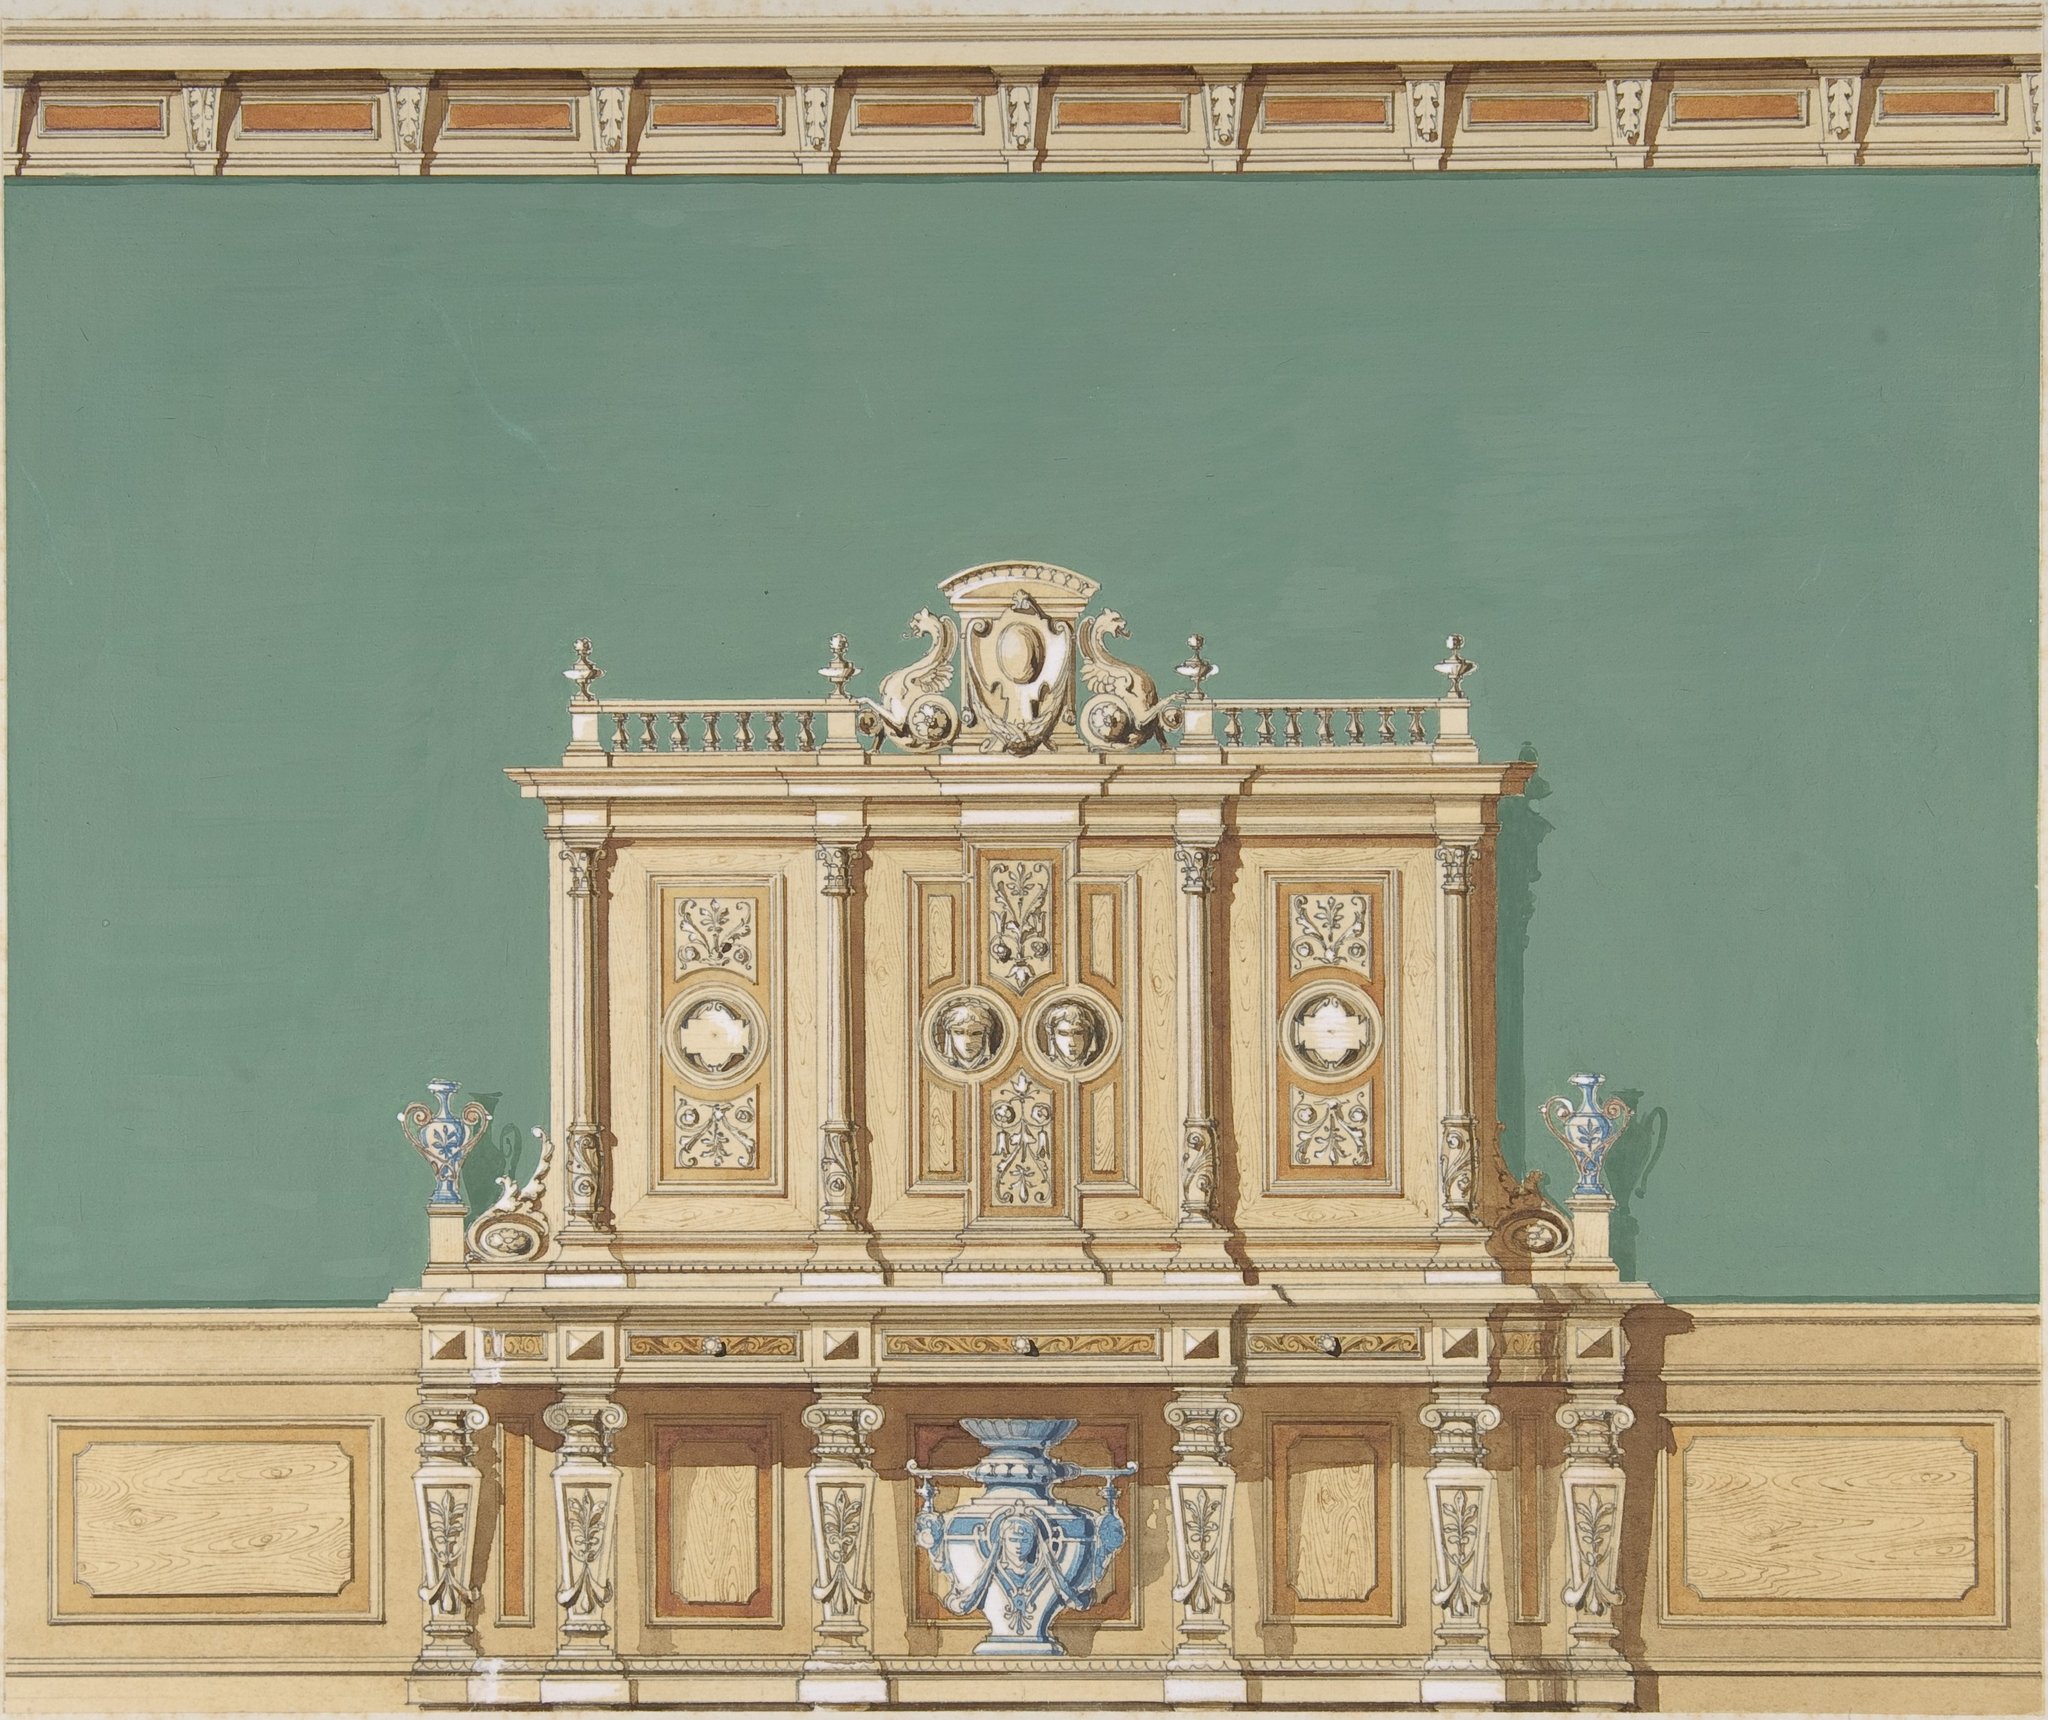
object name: drawing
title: Interior Design with a Large Renaissance Style Cabinet against a Green Wall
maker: anonymous, british, 19th century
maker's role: artist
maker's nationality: british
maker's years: 1800-1900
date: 1867-1900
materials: gouache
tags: faces,cabinets